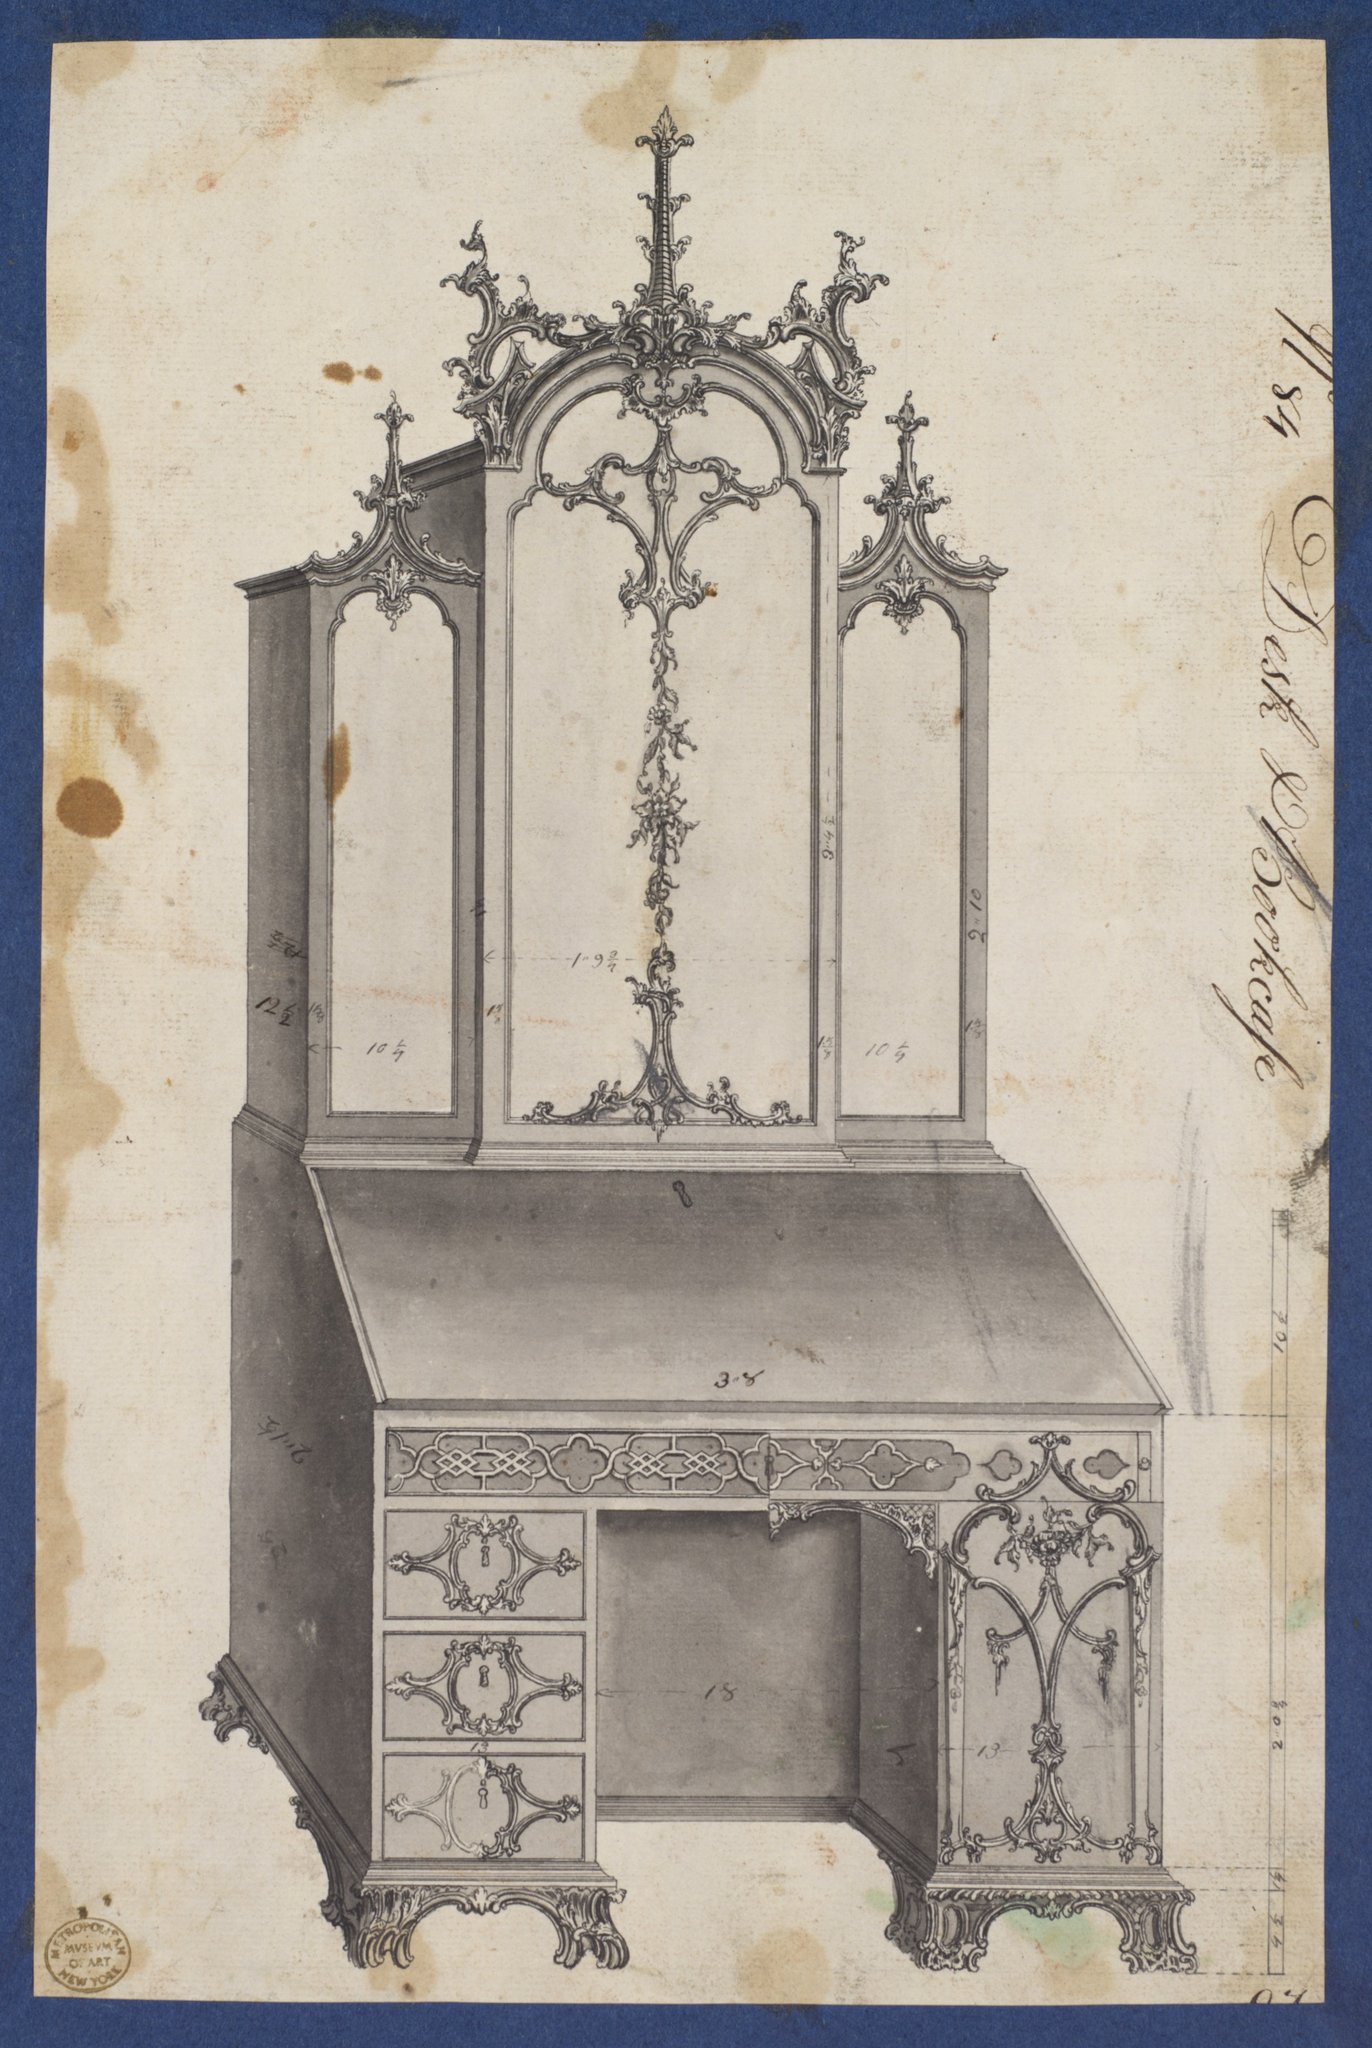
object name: drawing ornament architecture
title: Desk and Bookcase, from Chippendale Drawings, Vol. II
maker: thomas chippendale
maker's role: artist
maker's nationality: british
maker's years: 1718-1779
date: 1753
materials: ink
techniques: wash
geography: london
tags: desks